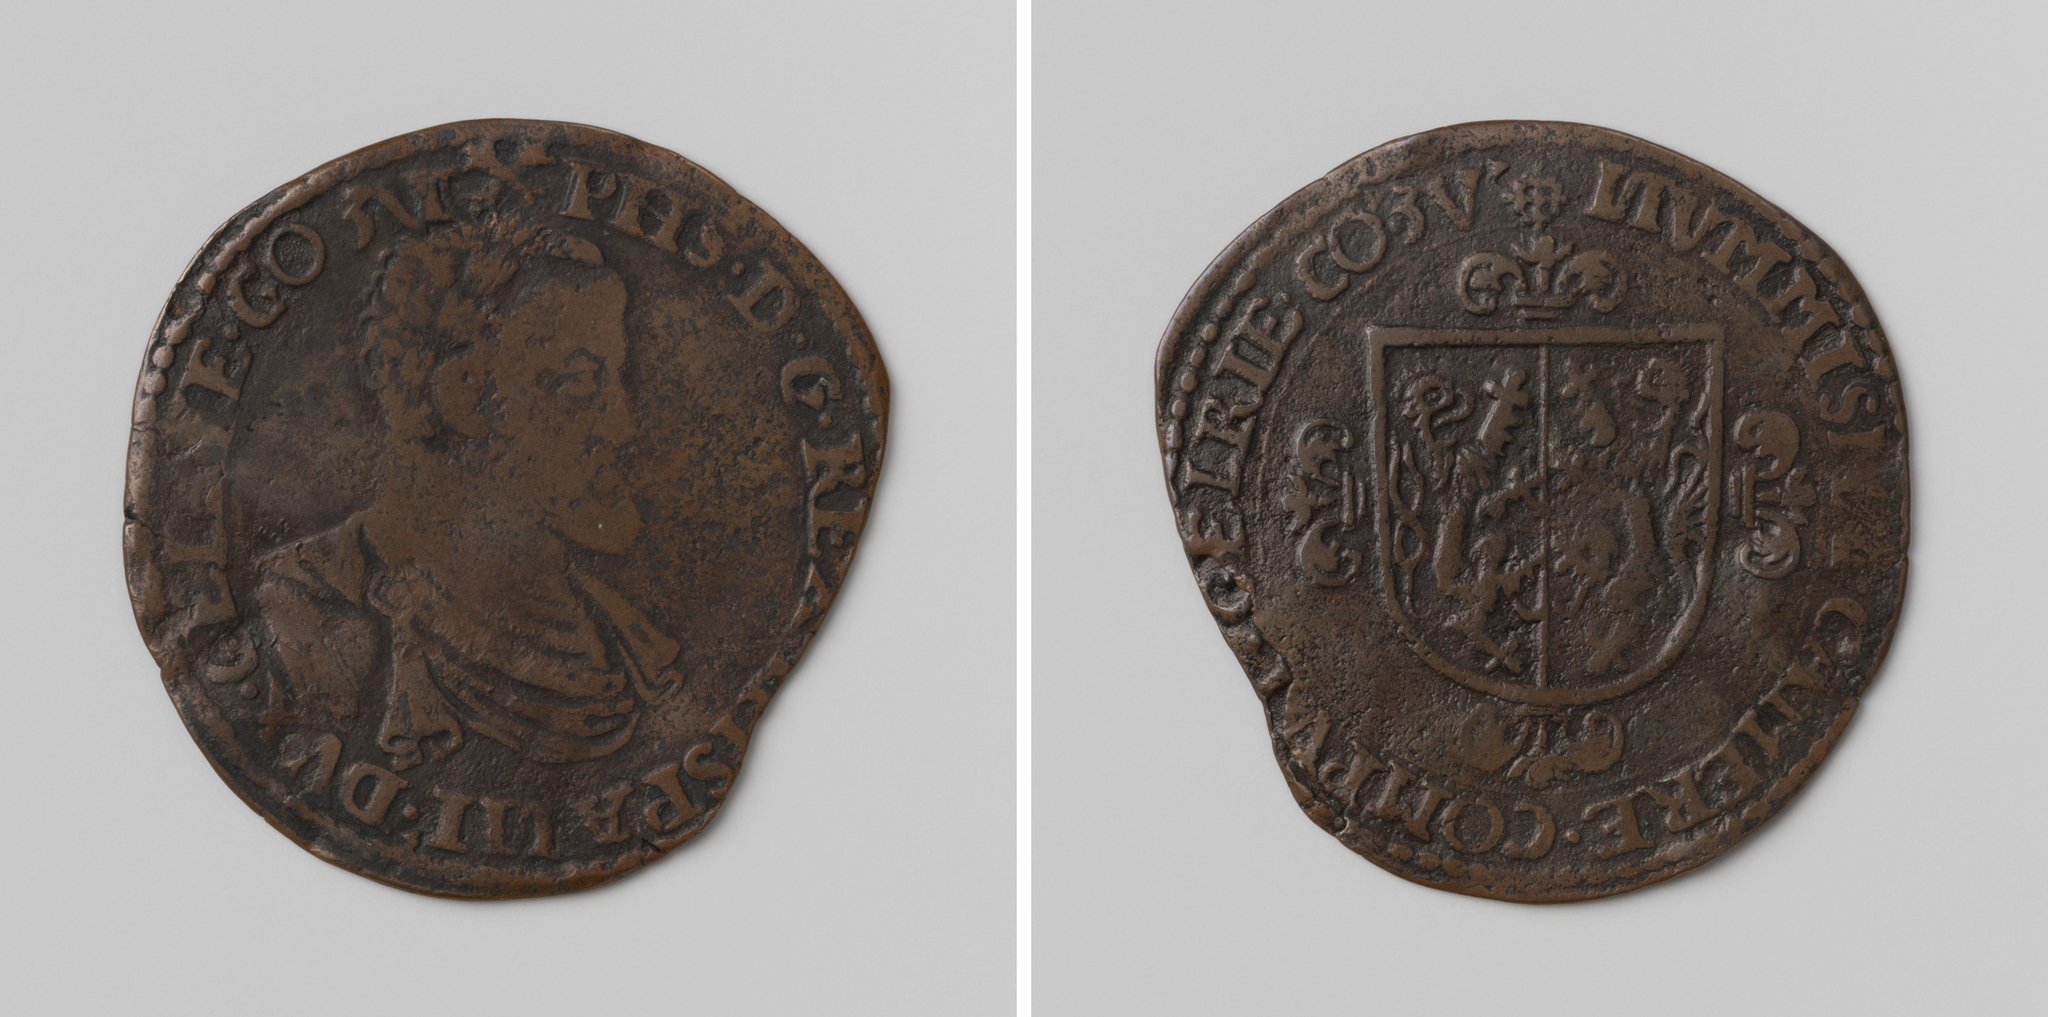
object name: jeton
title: Filips II, koning van Spanje, rekenpenning van de rekenkamer van Gelderland te Arnhem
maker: Anonymous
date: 1563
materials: copper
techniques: striking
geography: netherlands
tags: philip ii of spain, arnhem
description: Koperen penning. Voorzijde: borststuk man met lauwerkrans binnen omschrift. Keerzijde: wapenschild op gebloemd kruis binnen omschrift